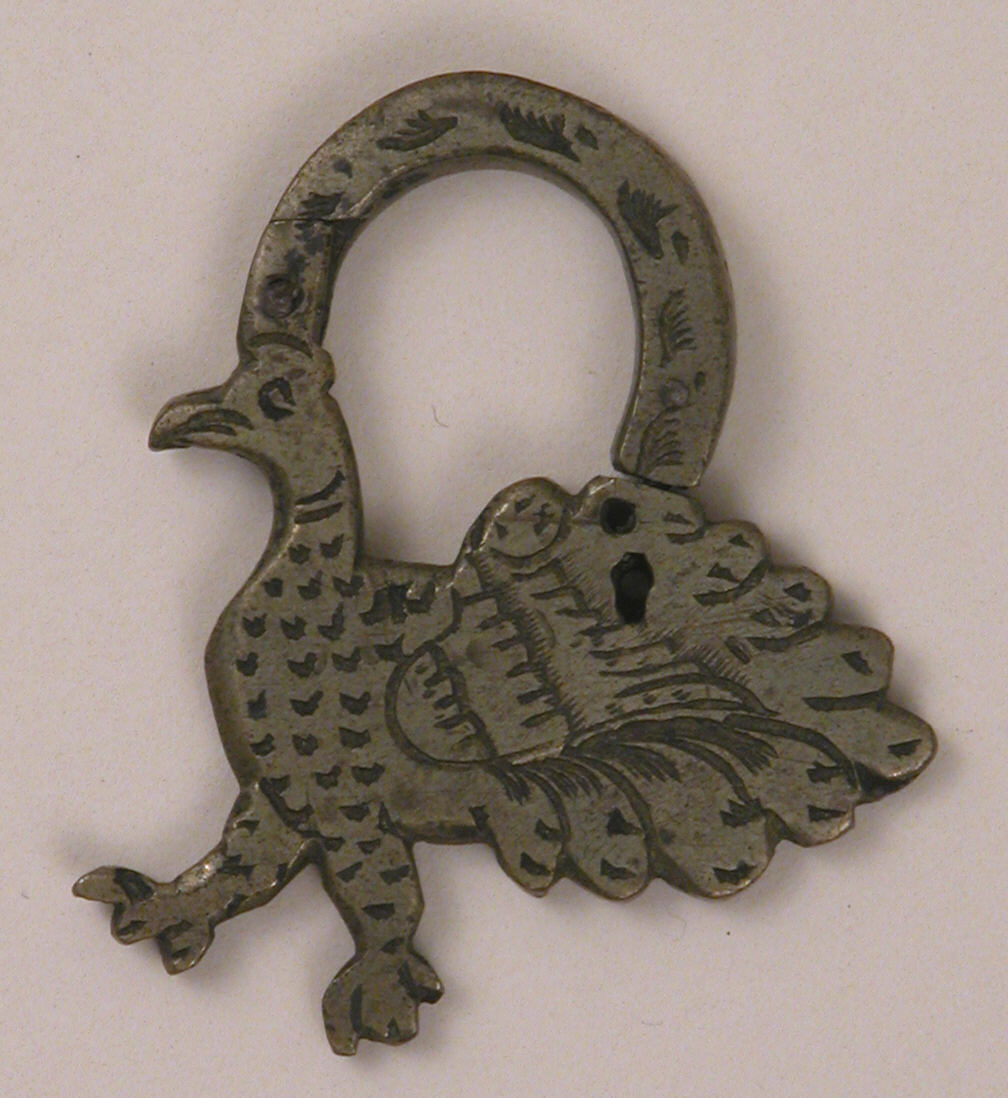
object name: padlock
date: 1701-1800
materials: brass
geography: india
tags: birds